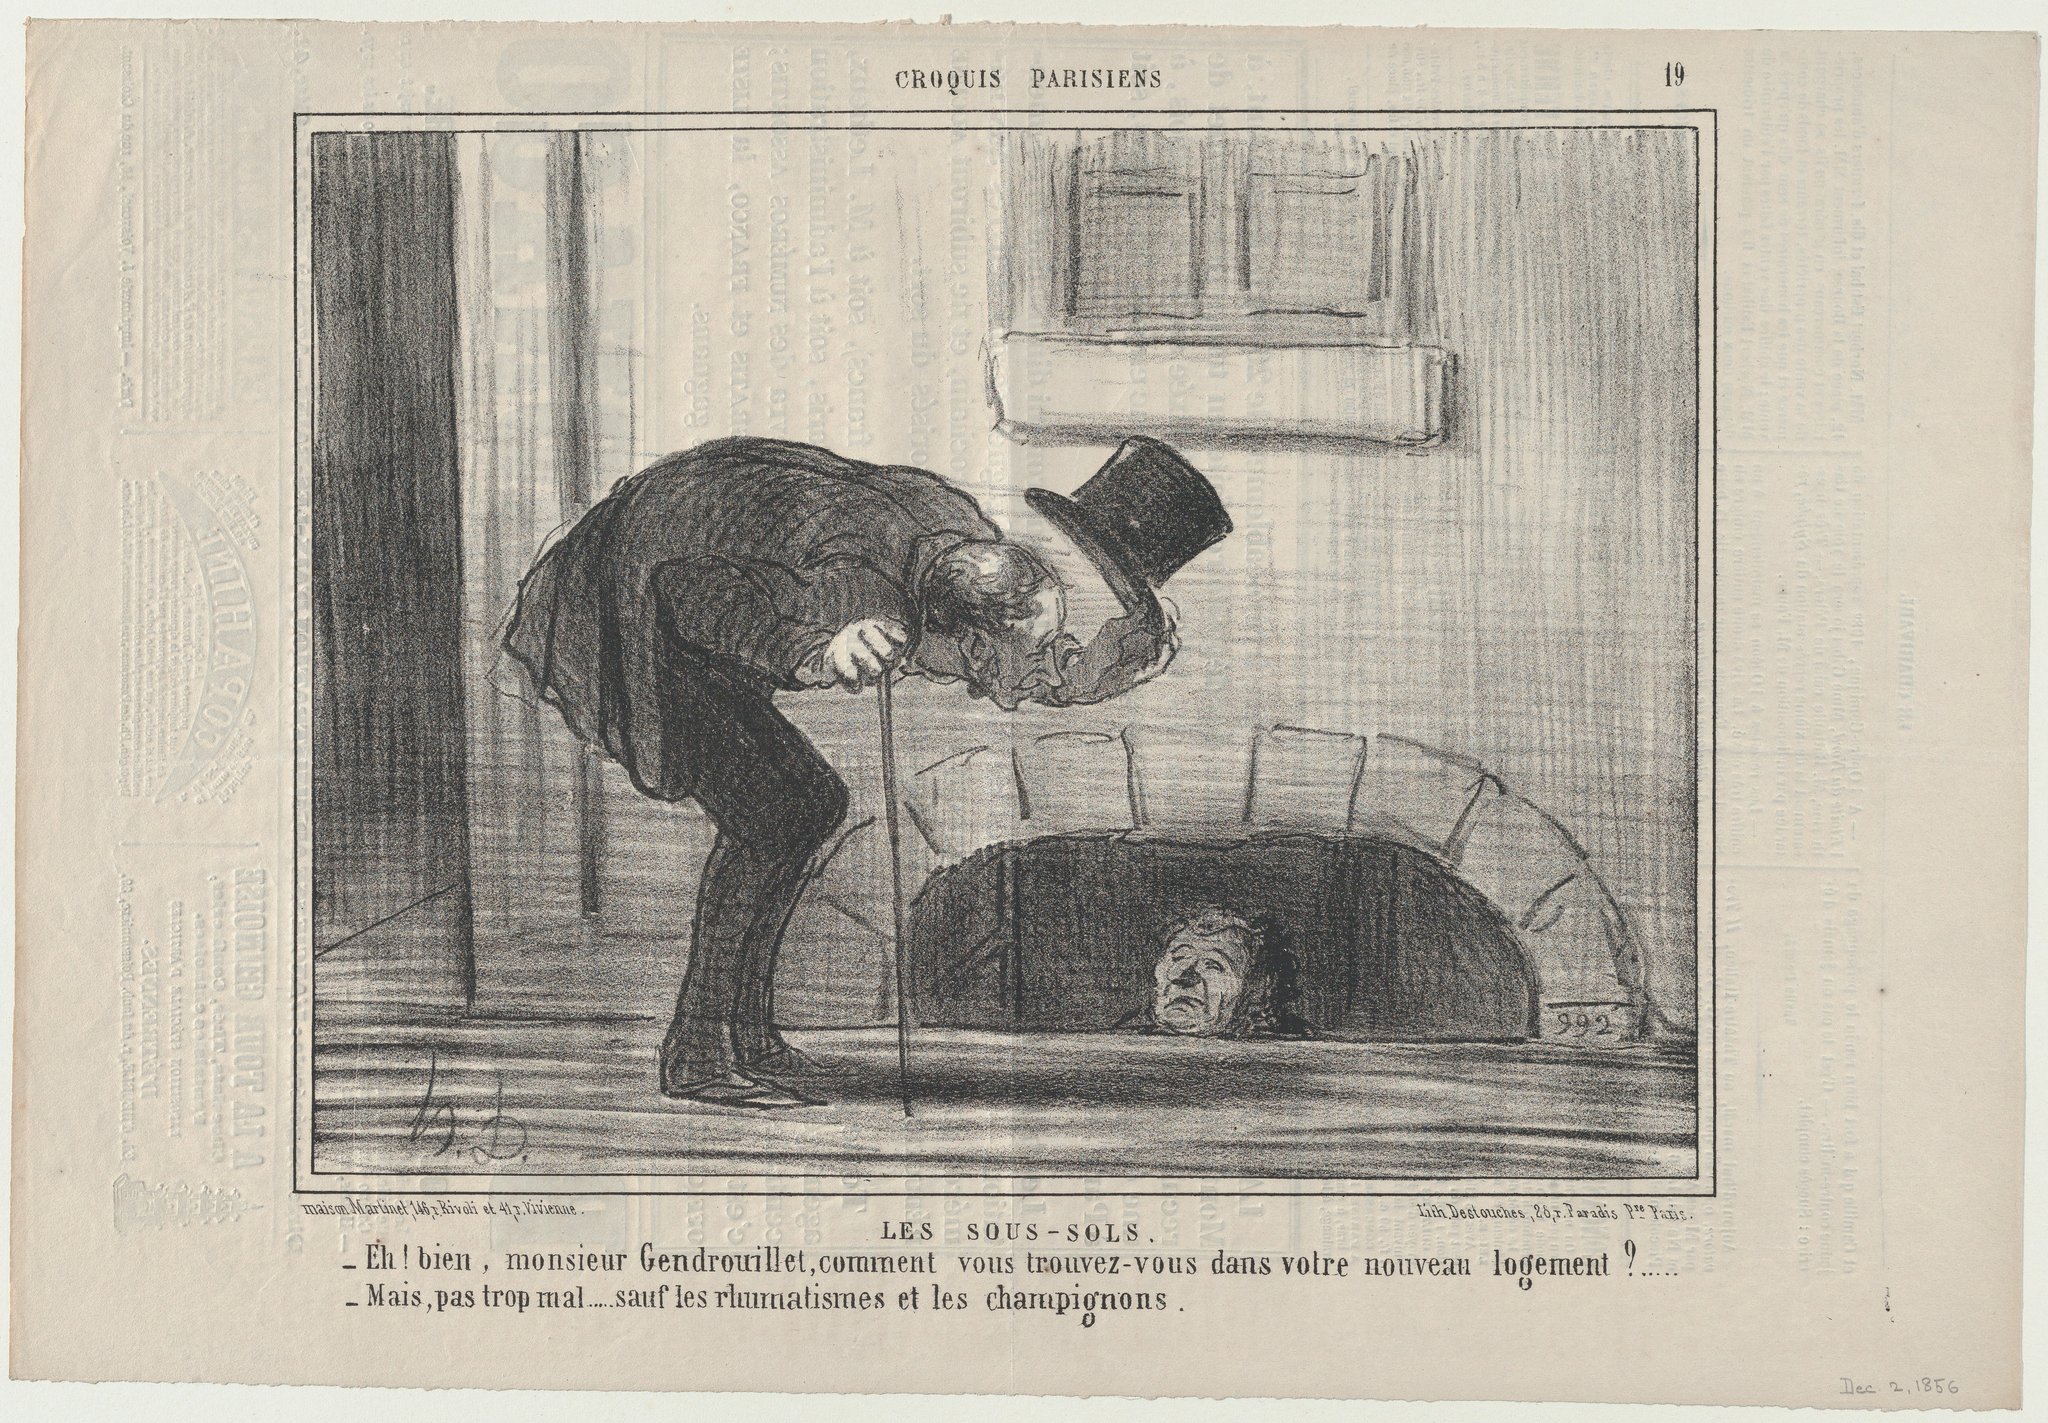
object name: print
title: Les Sous-Sols, from Croqius Parisiens, published in Le Charivari, December 2, 1856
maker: honoré daumier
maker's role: artist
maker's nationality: french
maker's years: 1808-1879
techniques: lithograph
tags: men